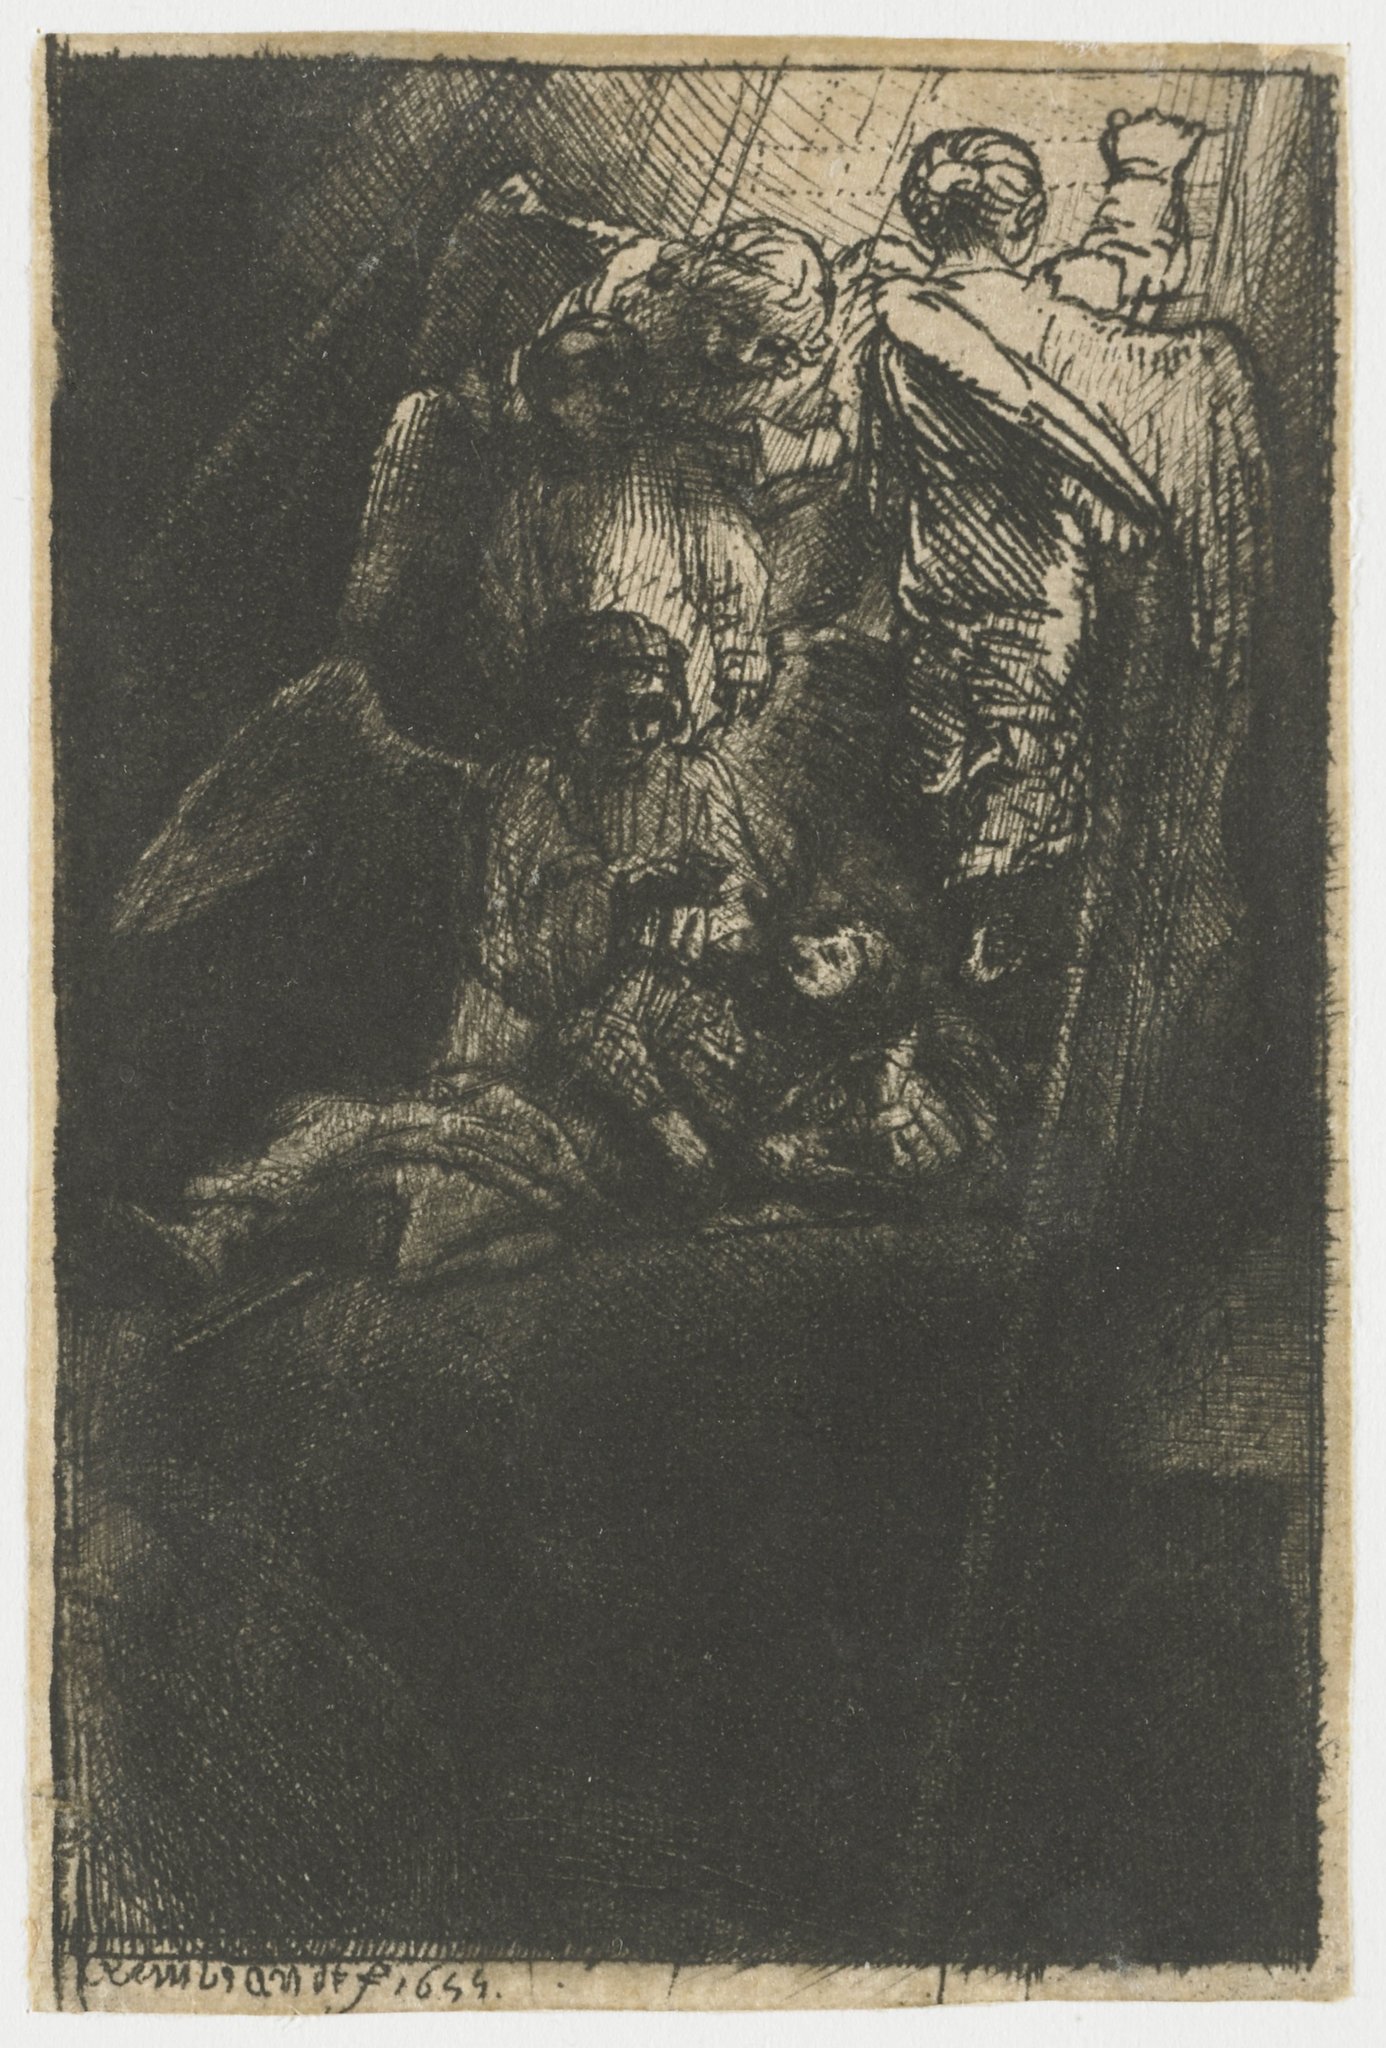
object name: print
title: Jacob's ladder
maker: rembrandt van rijn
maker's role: draughtsman, painter, print maker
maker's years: 1606-1669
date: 1655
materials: paper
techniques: drypoint, etching, intaglio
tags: the dream of jacob: while sleeping on the ground with a stone for pillow jacob sees a ladder reaching from earth to heaven with angels going up and down; usually with god at the top of the ladder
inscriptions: signature and date: ‘Rembrandt f 1655’, collector's mark: Lugt 240